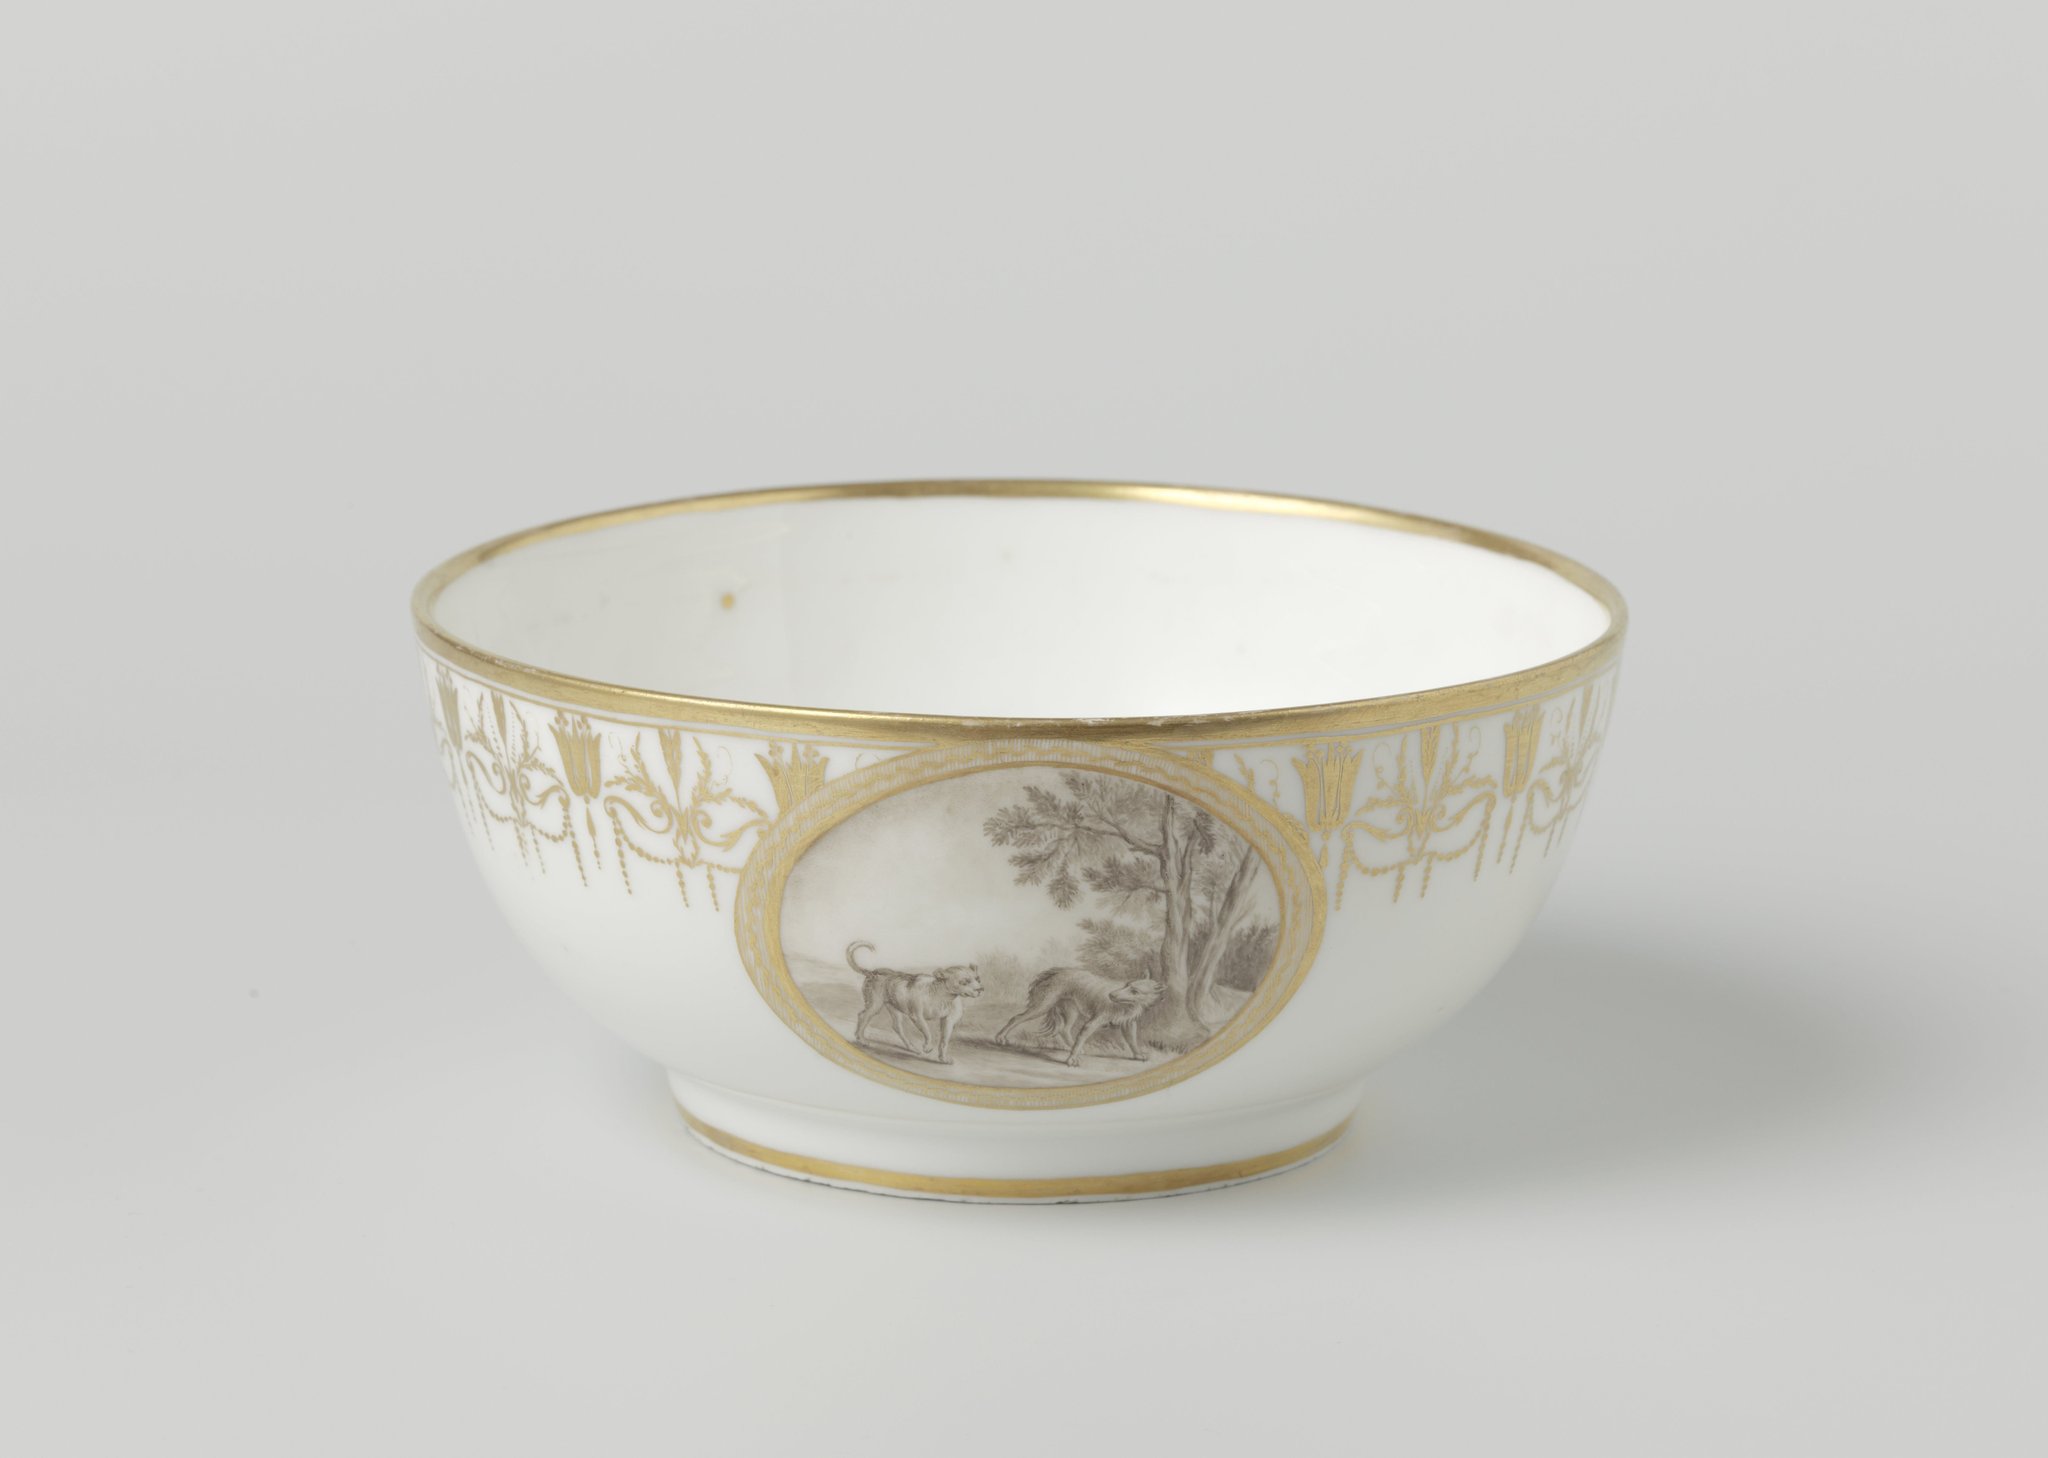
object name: bowl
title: Bowl with a dog and a wolf in a landscape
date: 1800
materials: glaze, gold, paint, porcelain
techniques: firing, gilding, turning, vitrification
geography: paris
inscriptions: mark: ‘NAST’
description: Kom van porselein, beschilderd op het glazuur in sepia en goud. Op de buitenwand een band met gestileerde bloemranken onderbroken door een medaillon met daarin een hond en een wolf in een landschap. Gouden rand en voet. Gemerkt op de onderzijde met 'NAST'.